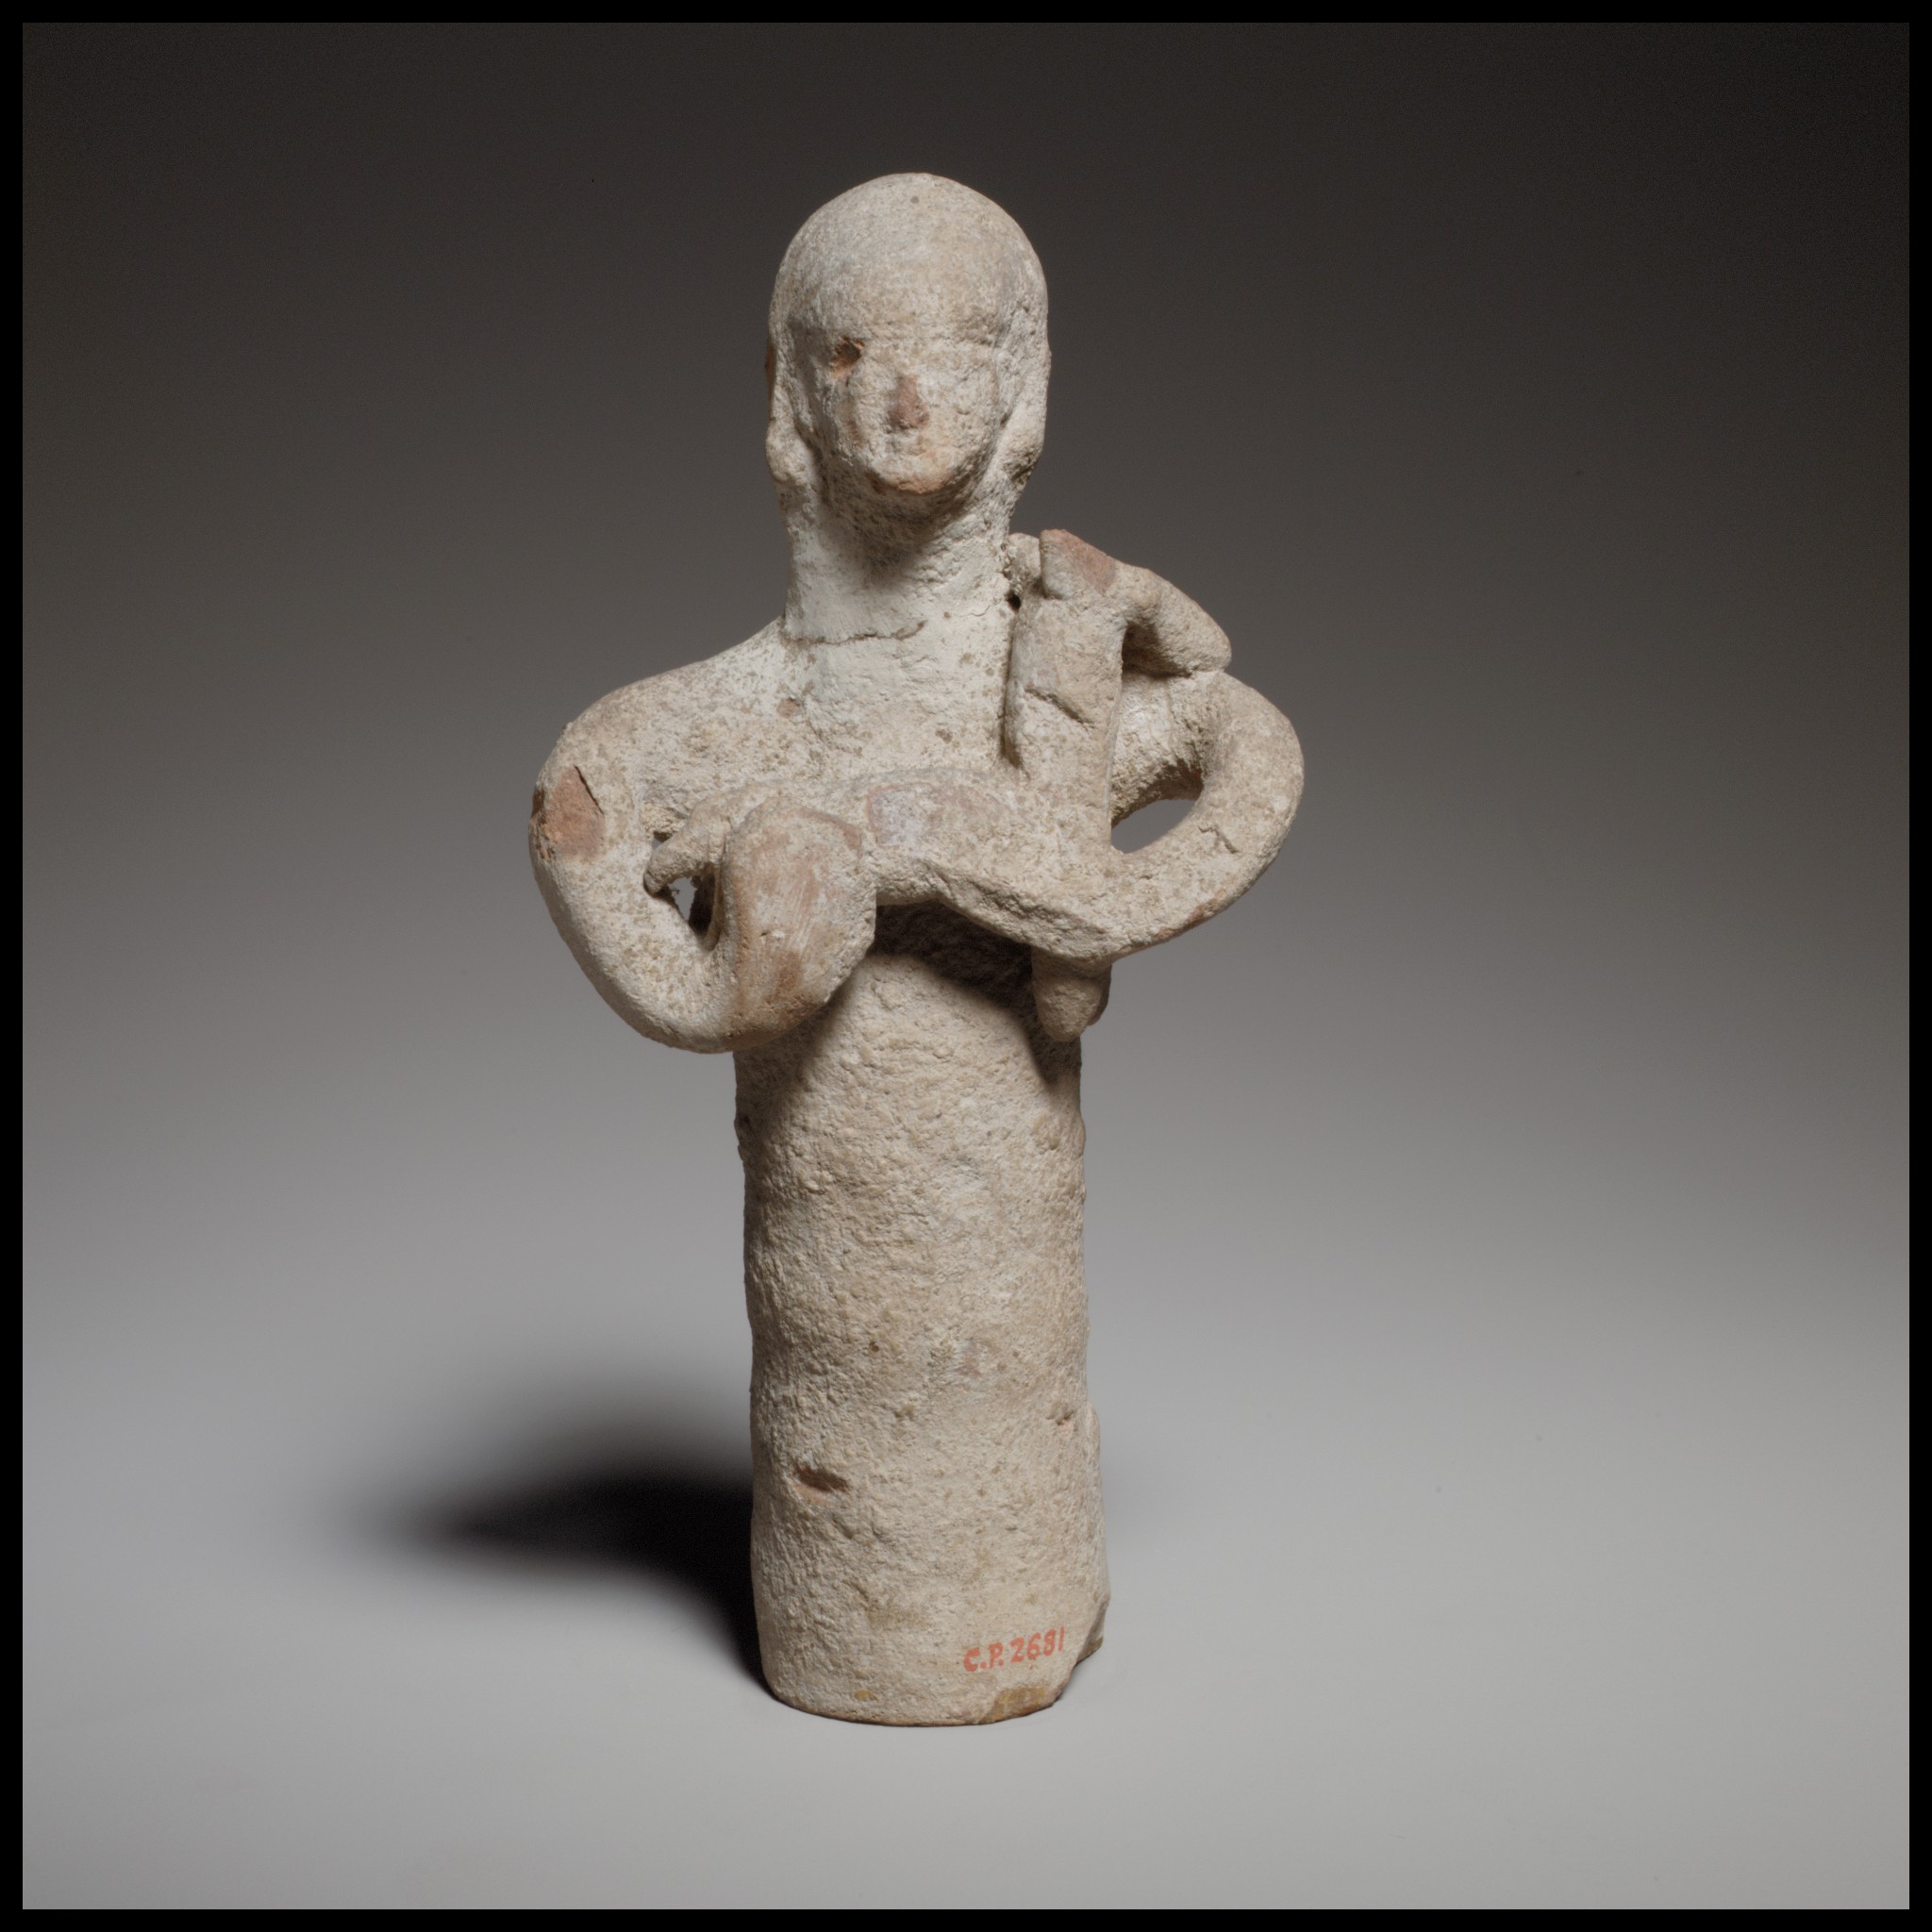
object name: statuette of a woman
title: Standing figurine holding a quadruped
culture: cypriot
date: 600-501 BCE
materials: terracotta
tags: human figures,animals